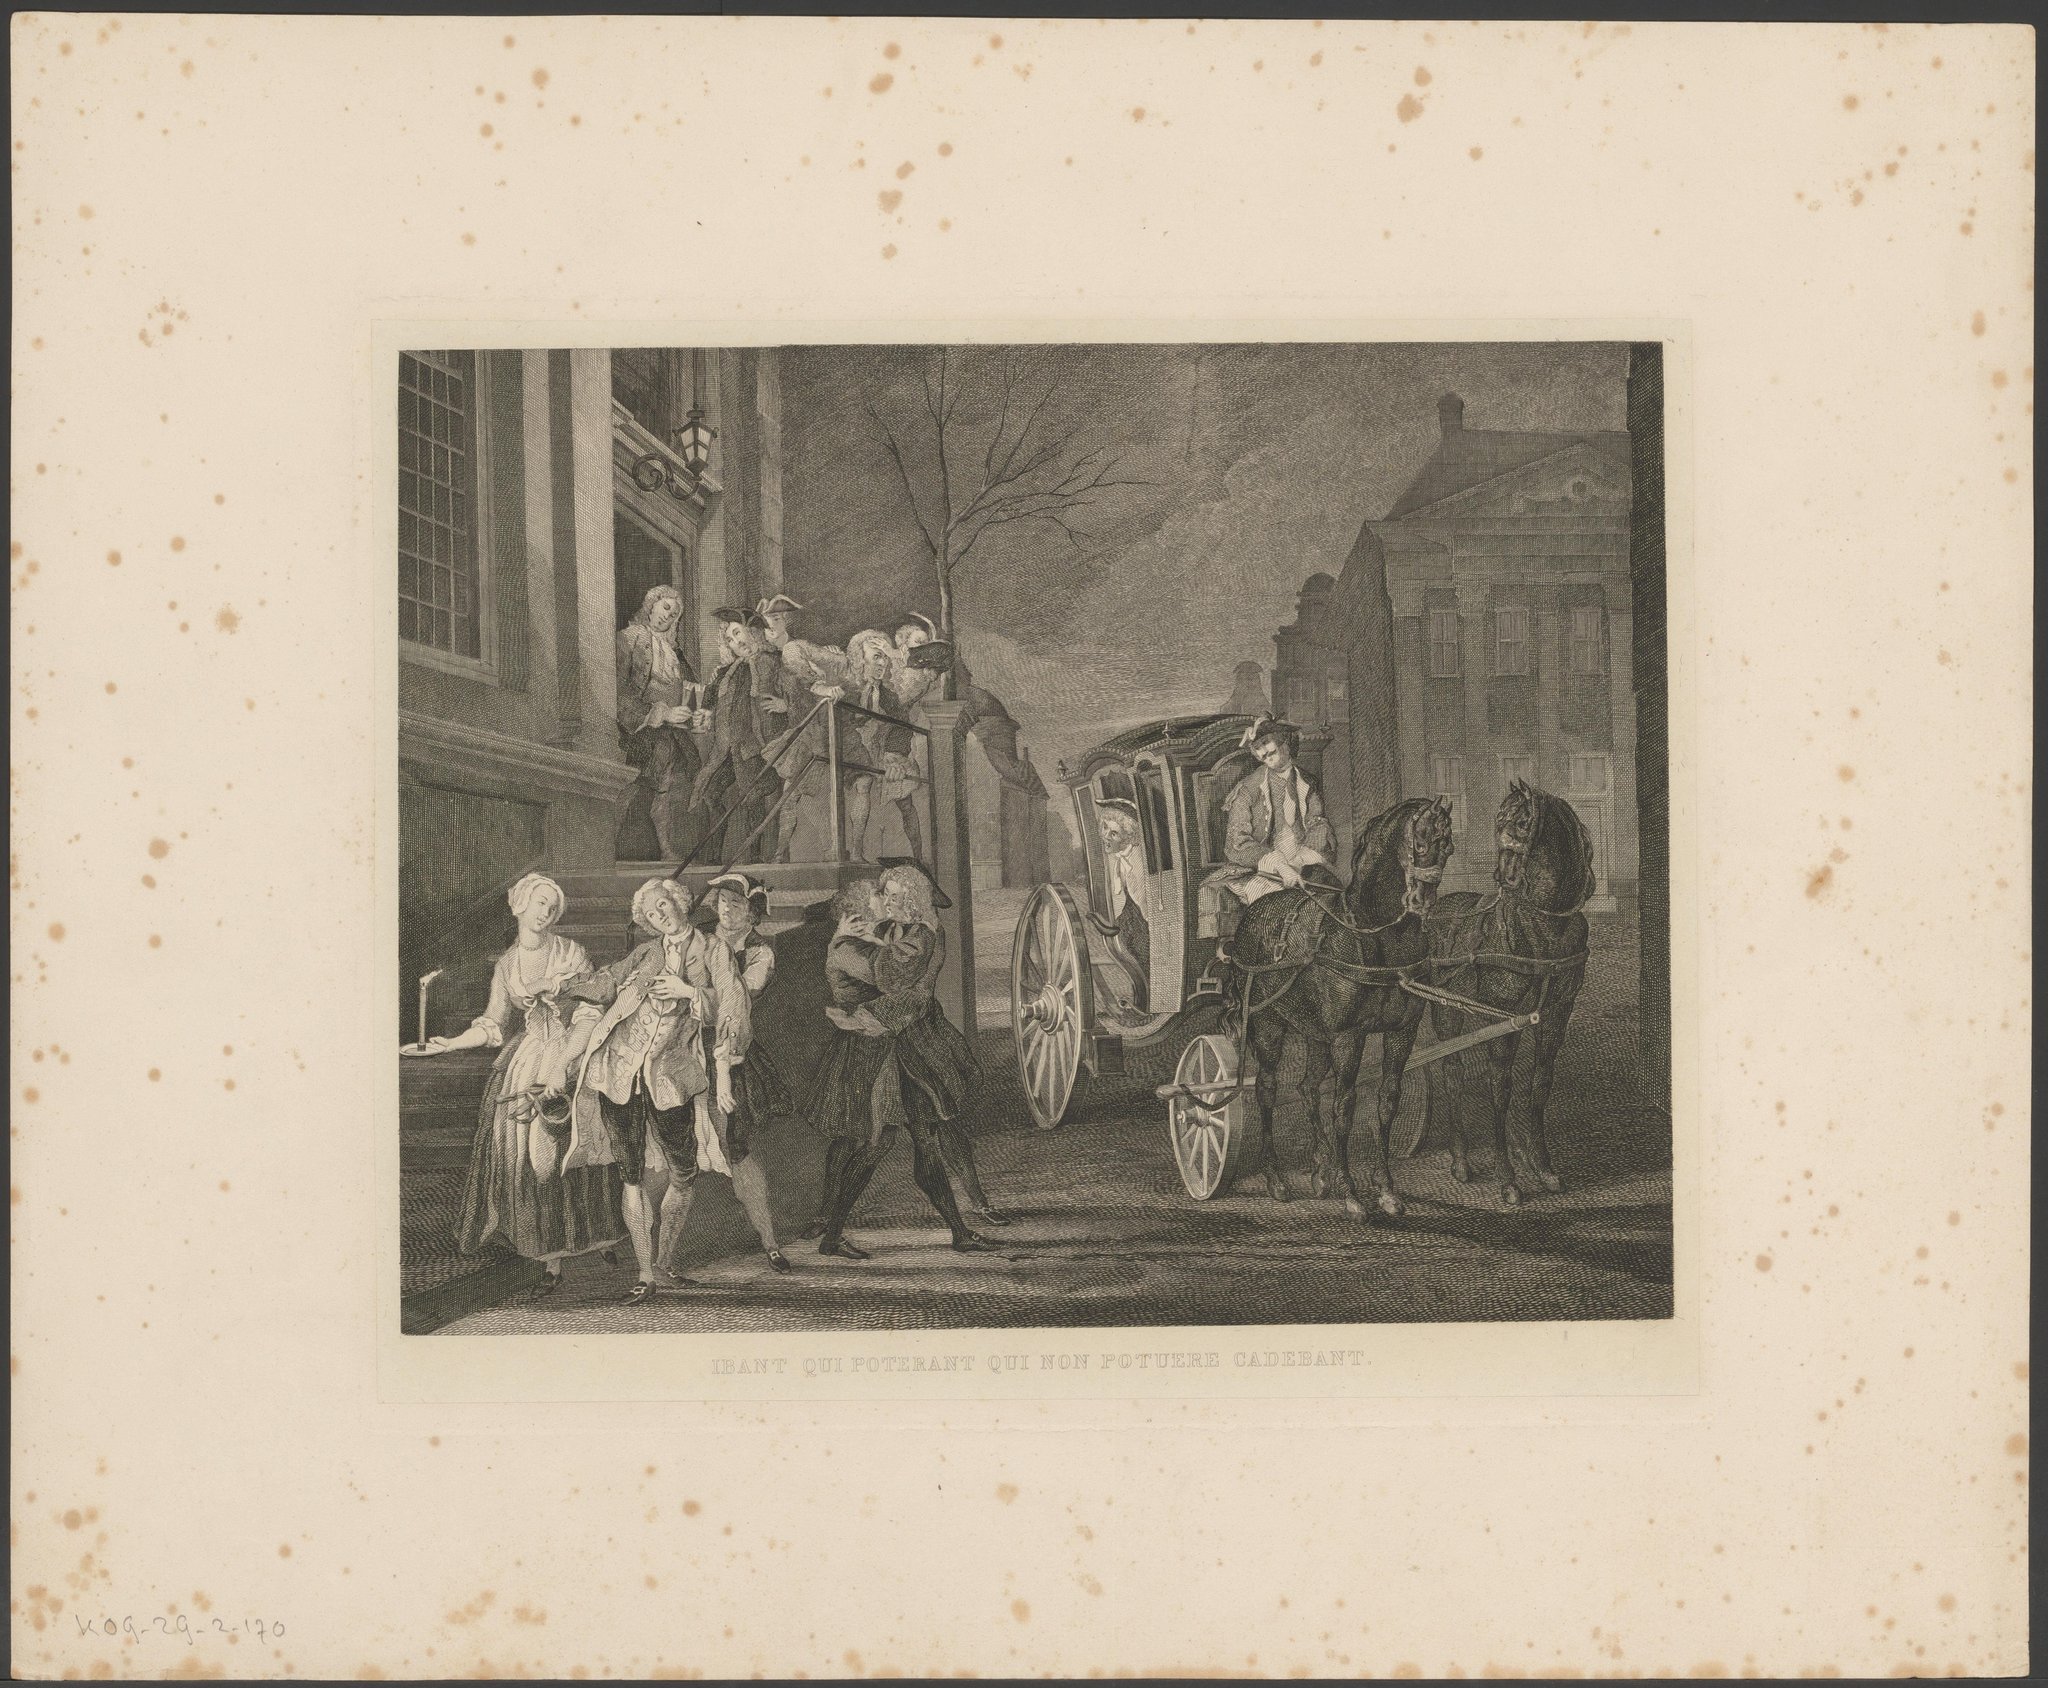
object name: print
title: De Nelri van C. Troost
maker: tieleman cato bruining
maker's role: print maker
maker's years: 1801-1877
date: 1850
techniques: printmaking, etching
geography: leiden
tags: embracing each other, kissing, drunkenness, four-wheeled vehicle drawn by two animals, celebration meal, feast, banquet - cc - out of doors (+ toast at meal, banquet)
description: Na een diner verlaat een groep dronken mannen het huis. Sommigen kunnen niet meer zelf lopen en moeten door de dienaar in de koets geholpen worden. In de deuropening toosten twee mannen nog eens op de avond. Onder de trap staan twee mannen te zoenen. Behoort bij de omslag voor de Nelri-prentenserie in zes exemplaren en het tekstblad met toelichting.